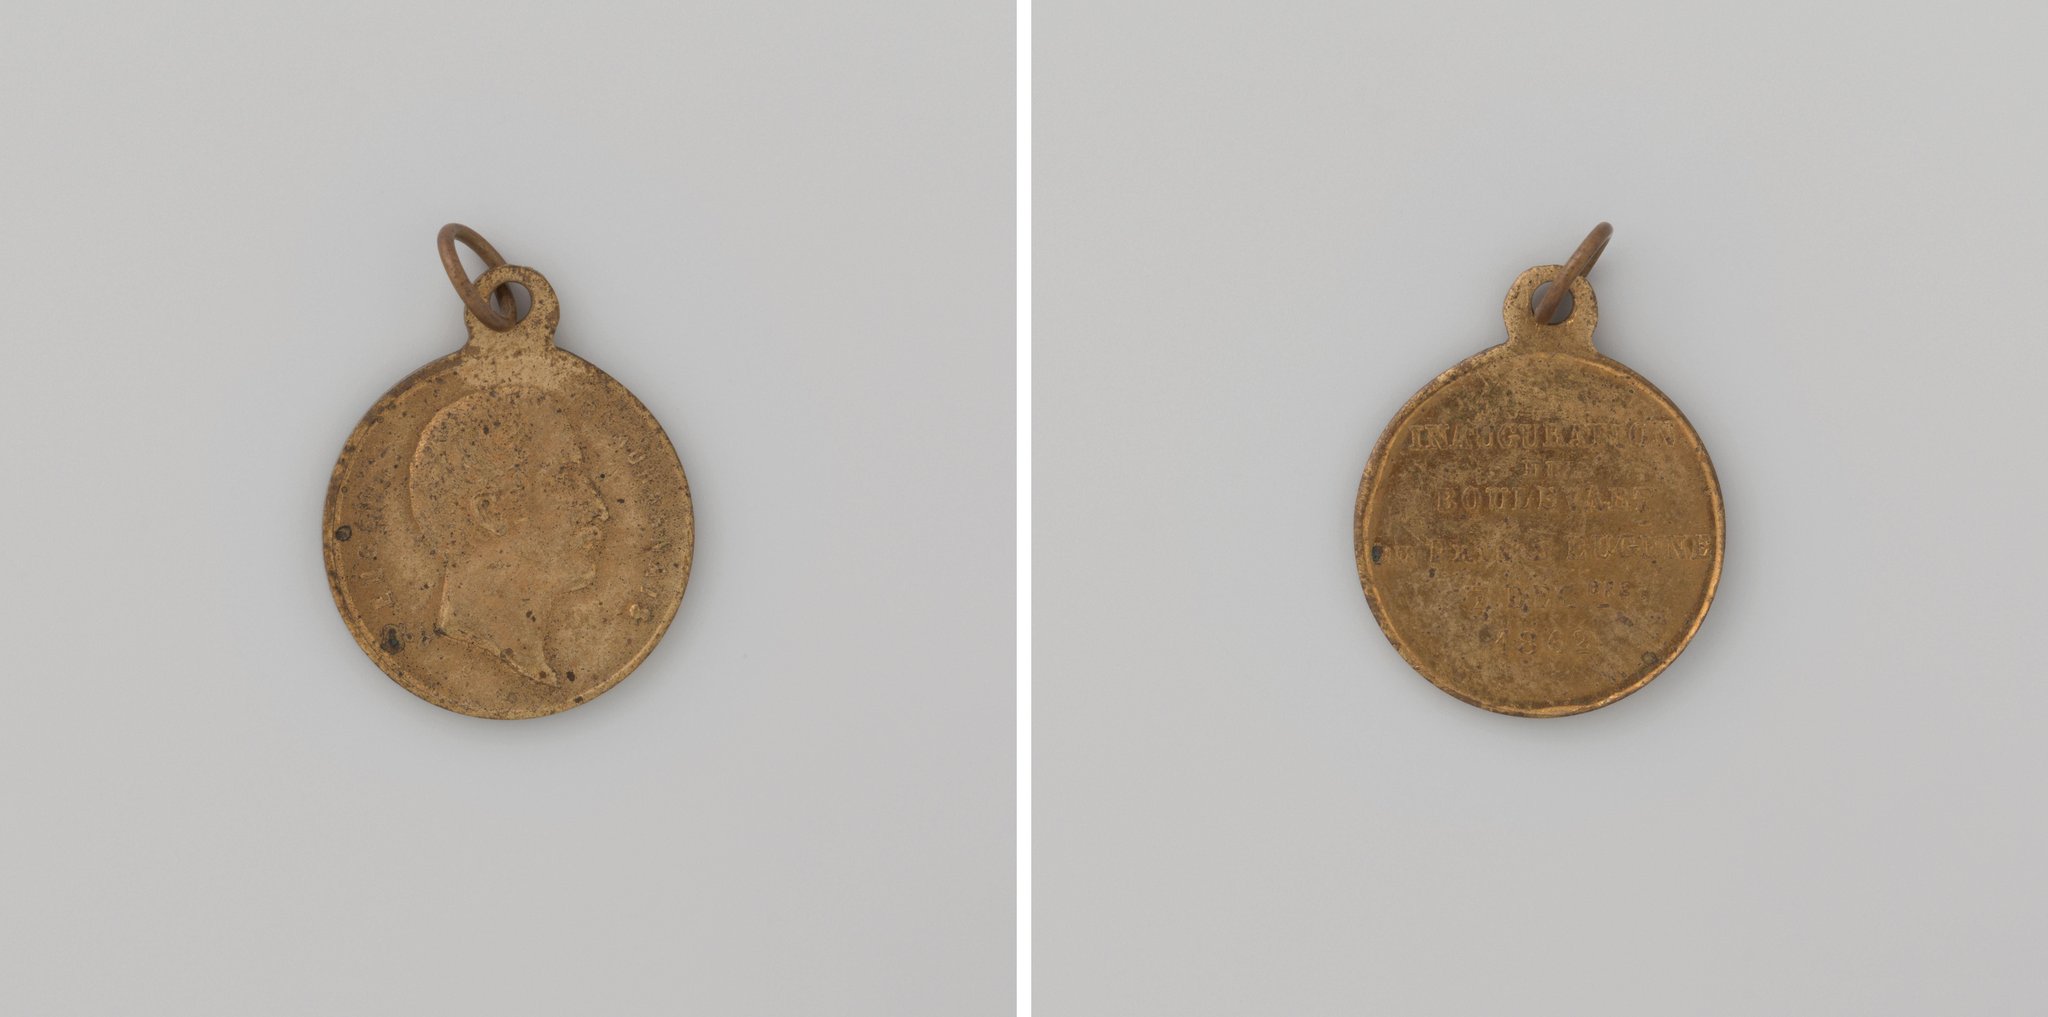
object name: history medal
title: Inwijding van de Boulevard Eugene, penning met borstbeeld van Eugene de Beauharnais, onderkoning van Italië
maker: monogrammist ct (medailleur)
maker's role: medailleur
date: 1862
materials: copper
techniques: gilding, striking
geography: paris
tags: eugène de beauharnais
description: Koperen penning aan draagoog en draagring. Voorzijde: borststuk man naar rechts binnen omschrift. Keerzijde: opschrift.